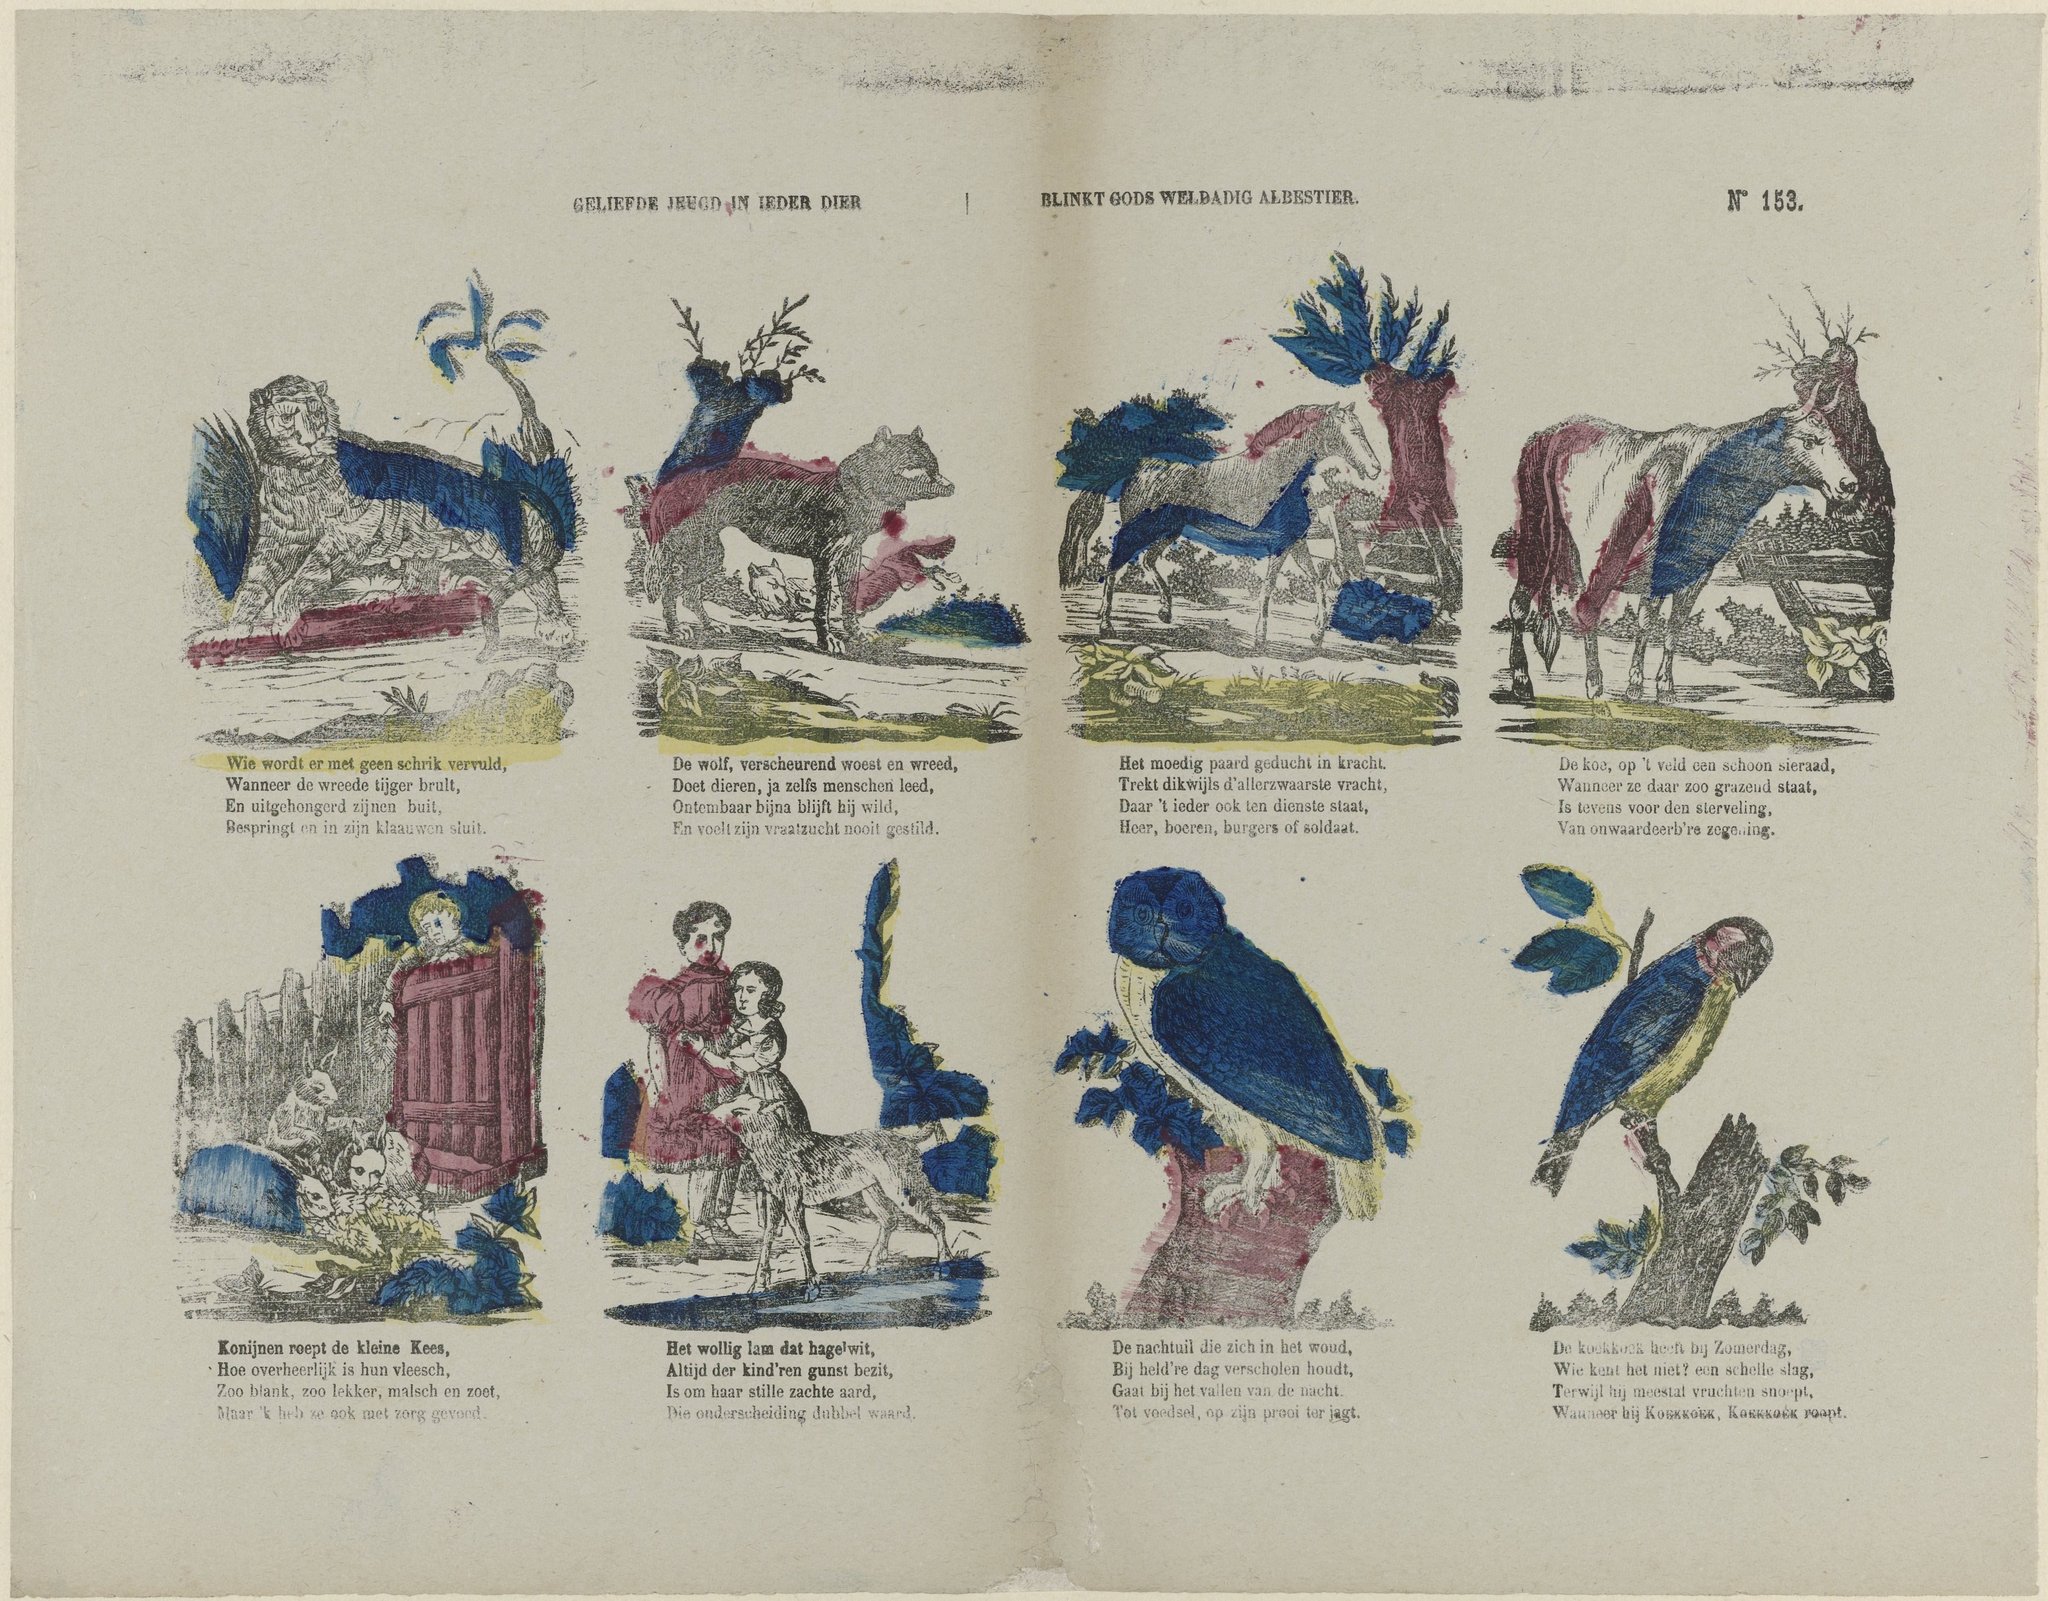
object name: print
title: Geliefde jeugd in ieder dier / Blinkt Gods weldadig albestier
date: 1827-1894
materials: paper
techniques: colour, letterpress printing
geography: schaarbeek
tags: beasts of prey, predatory animals: tiger, cow, animals, birds, owls, horse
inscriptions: collector's mark: Lugt 2760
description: Blad met 8 voorstellingen van dieren, zoals een tijger, een wolf, een paard en een uil. Onder elke voorstelling een vierregelig vers. Genummerd rechtsboven: No 153.